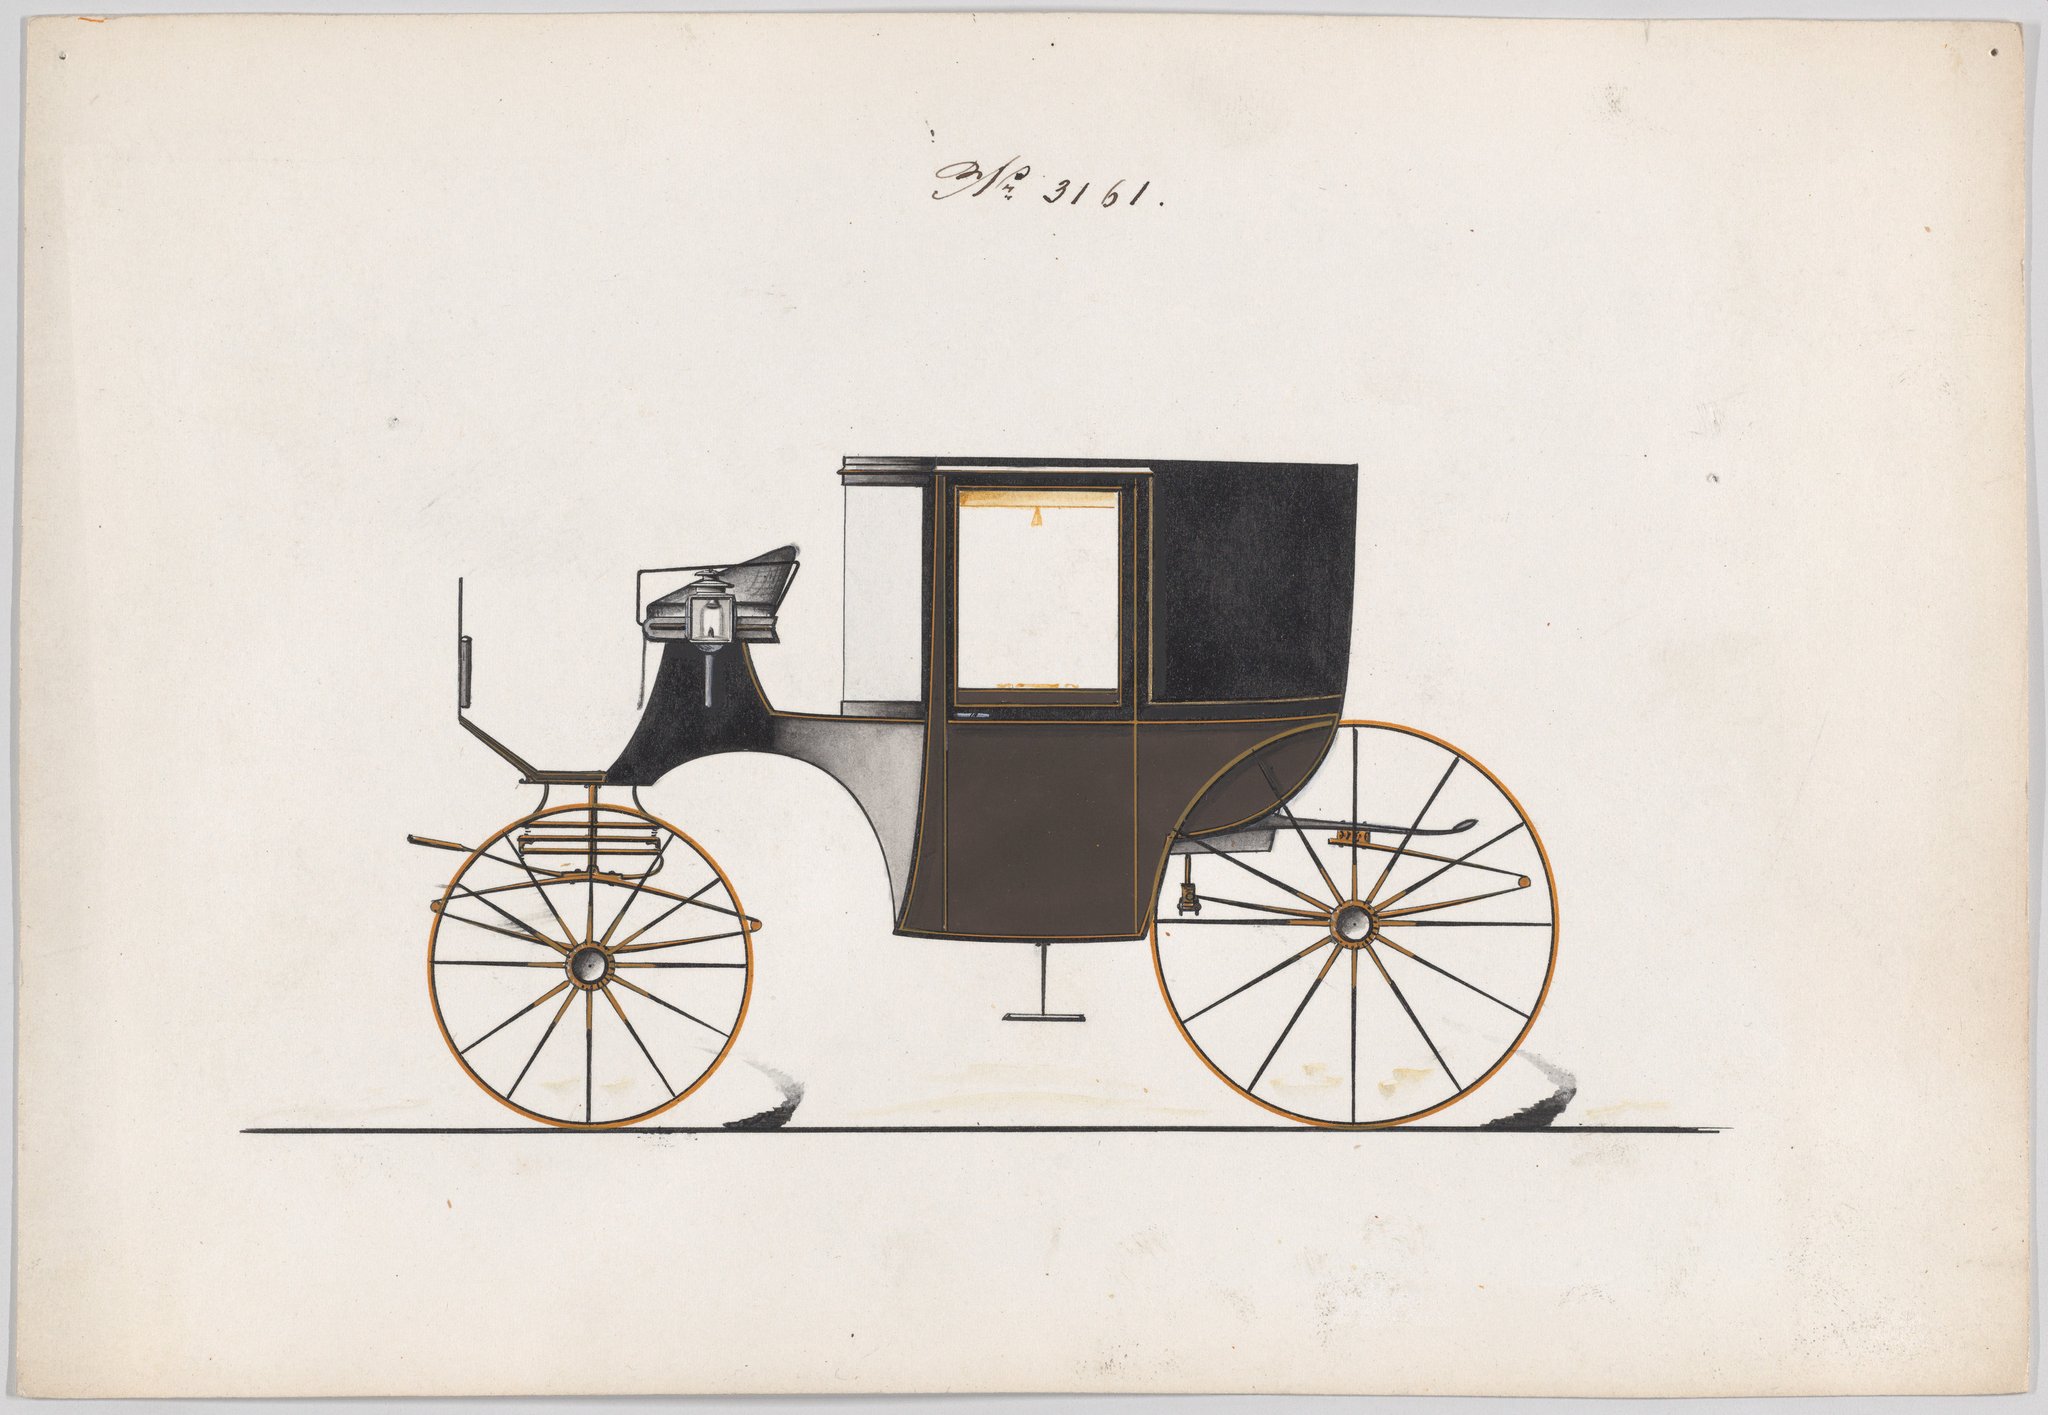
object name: drawing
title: Design for Coupé, no. 3161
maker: brewster & co.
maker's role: manufacturer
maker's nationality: american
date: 1875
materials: gouache, gum arabic, ink, watercolor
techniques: pen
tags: carriages